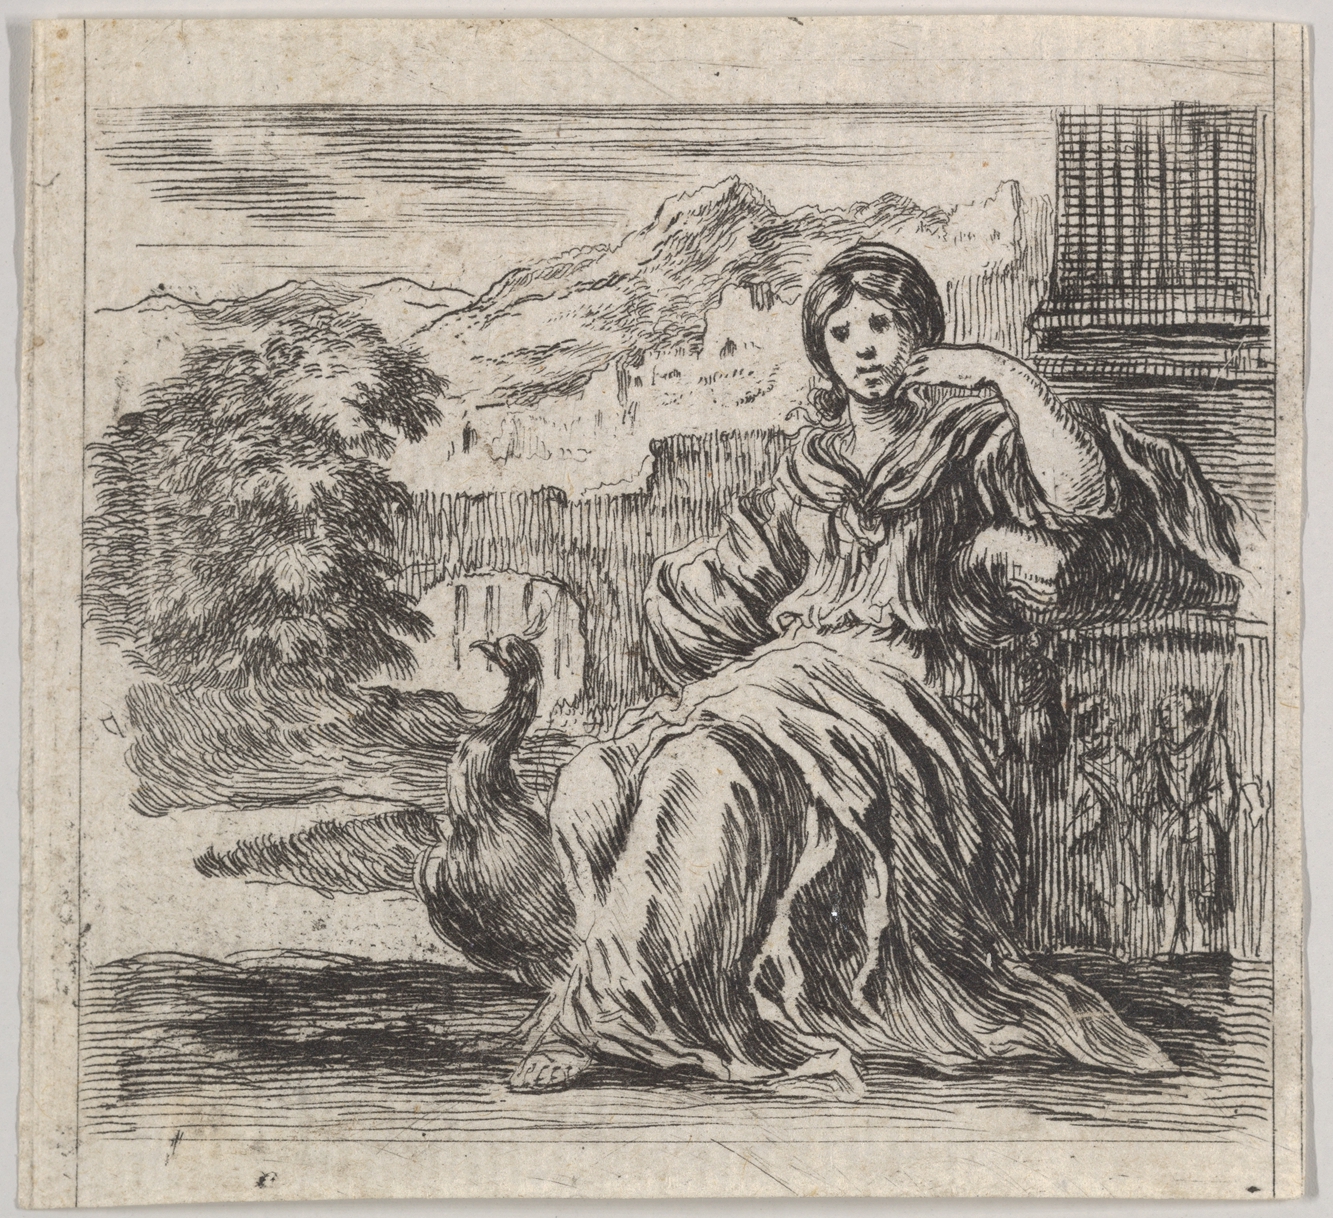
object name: print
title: Juno, from "Game of Mythology" (Jeu de la Mythologie)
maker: stefano della bella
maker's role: artist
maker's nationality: italian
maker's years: 1610-1664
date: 1644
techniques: etching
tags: birds,juno